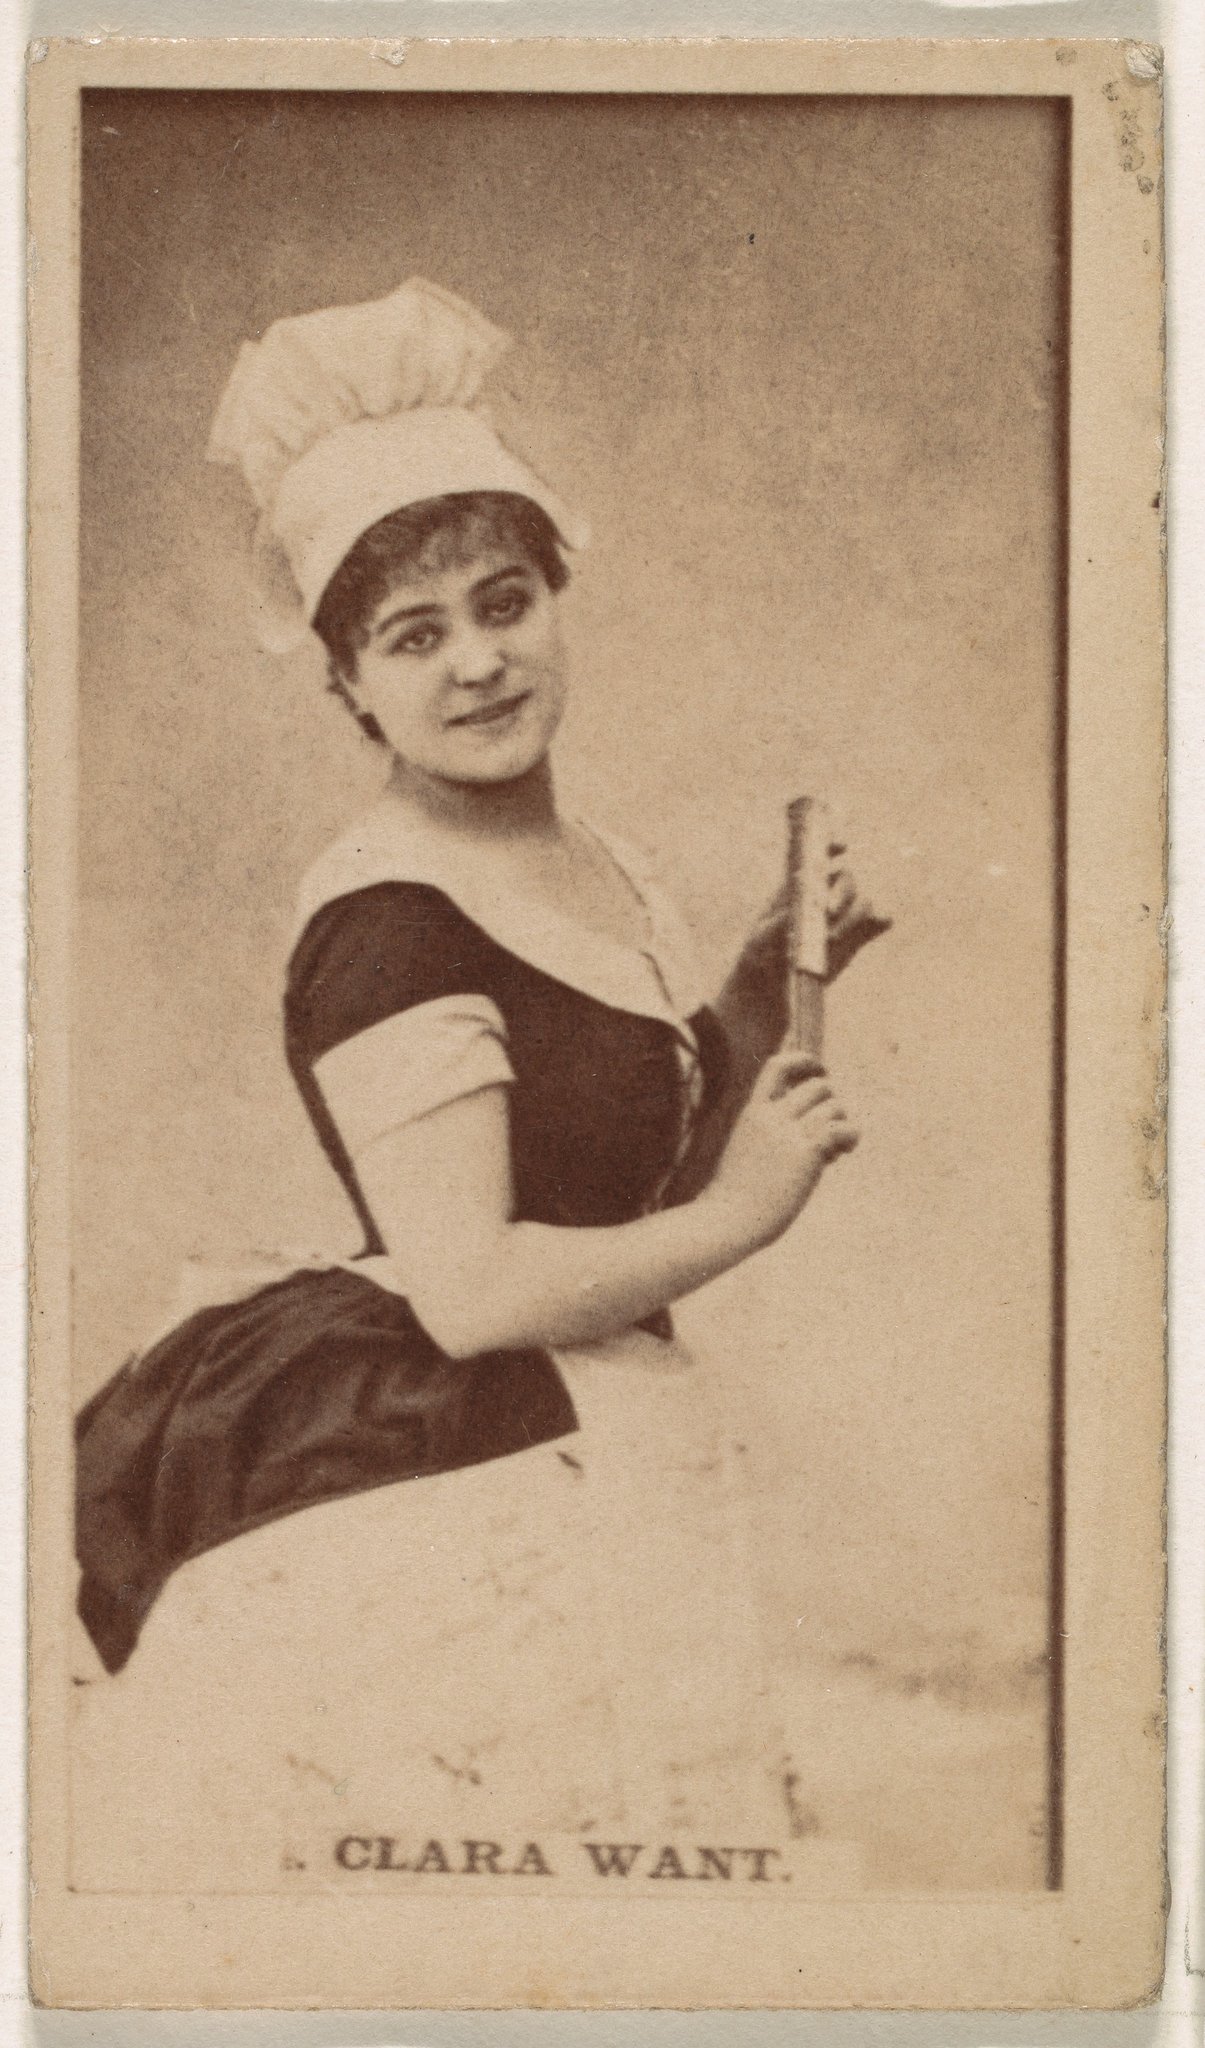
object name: photograph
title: Clara Want, from the Actresses series (N245) issued by Kinney Brothers to promote Sweet Caporal Cigarettes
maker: kinney brothers tobacco company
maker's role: publisher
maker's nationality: american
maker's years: 1869-2011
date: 1890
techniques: albumen silver print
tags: portraits,women,actresses